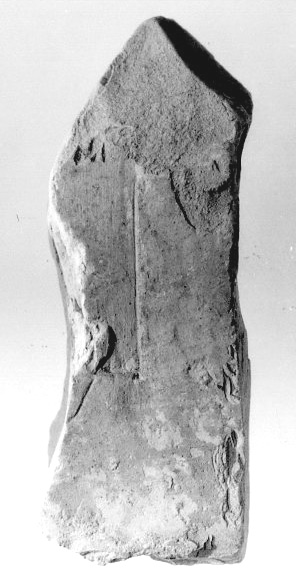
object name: relief fragment, tomb of meketre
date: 1981-1975 BCE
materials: limestone, paint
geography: egypt